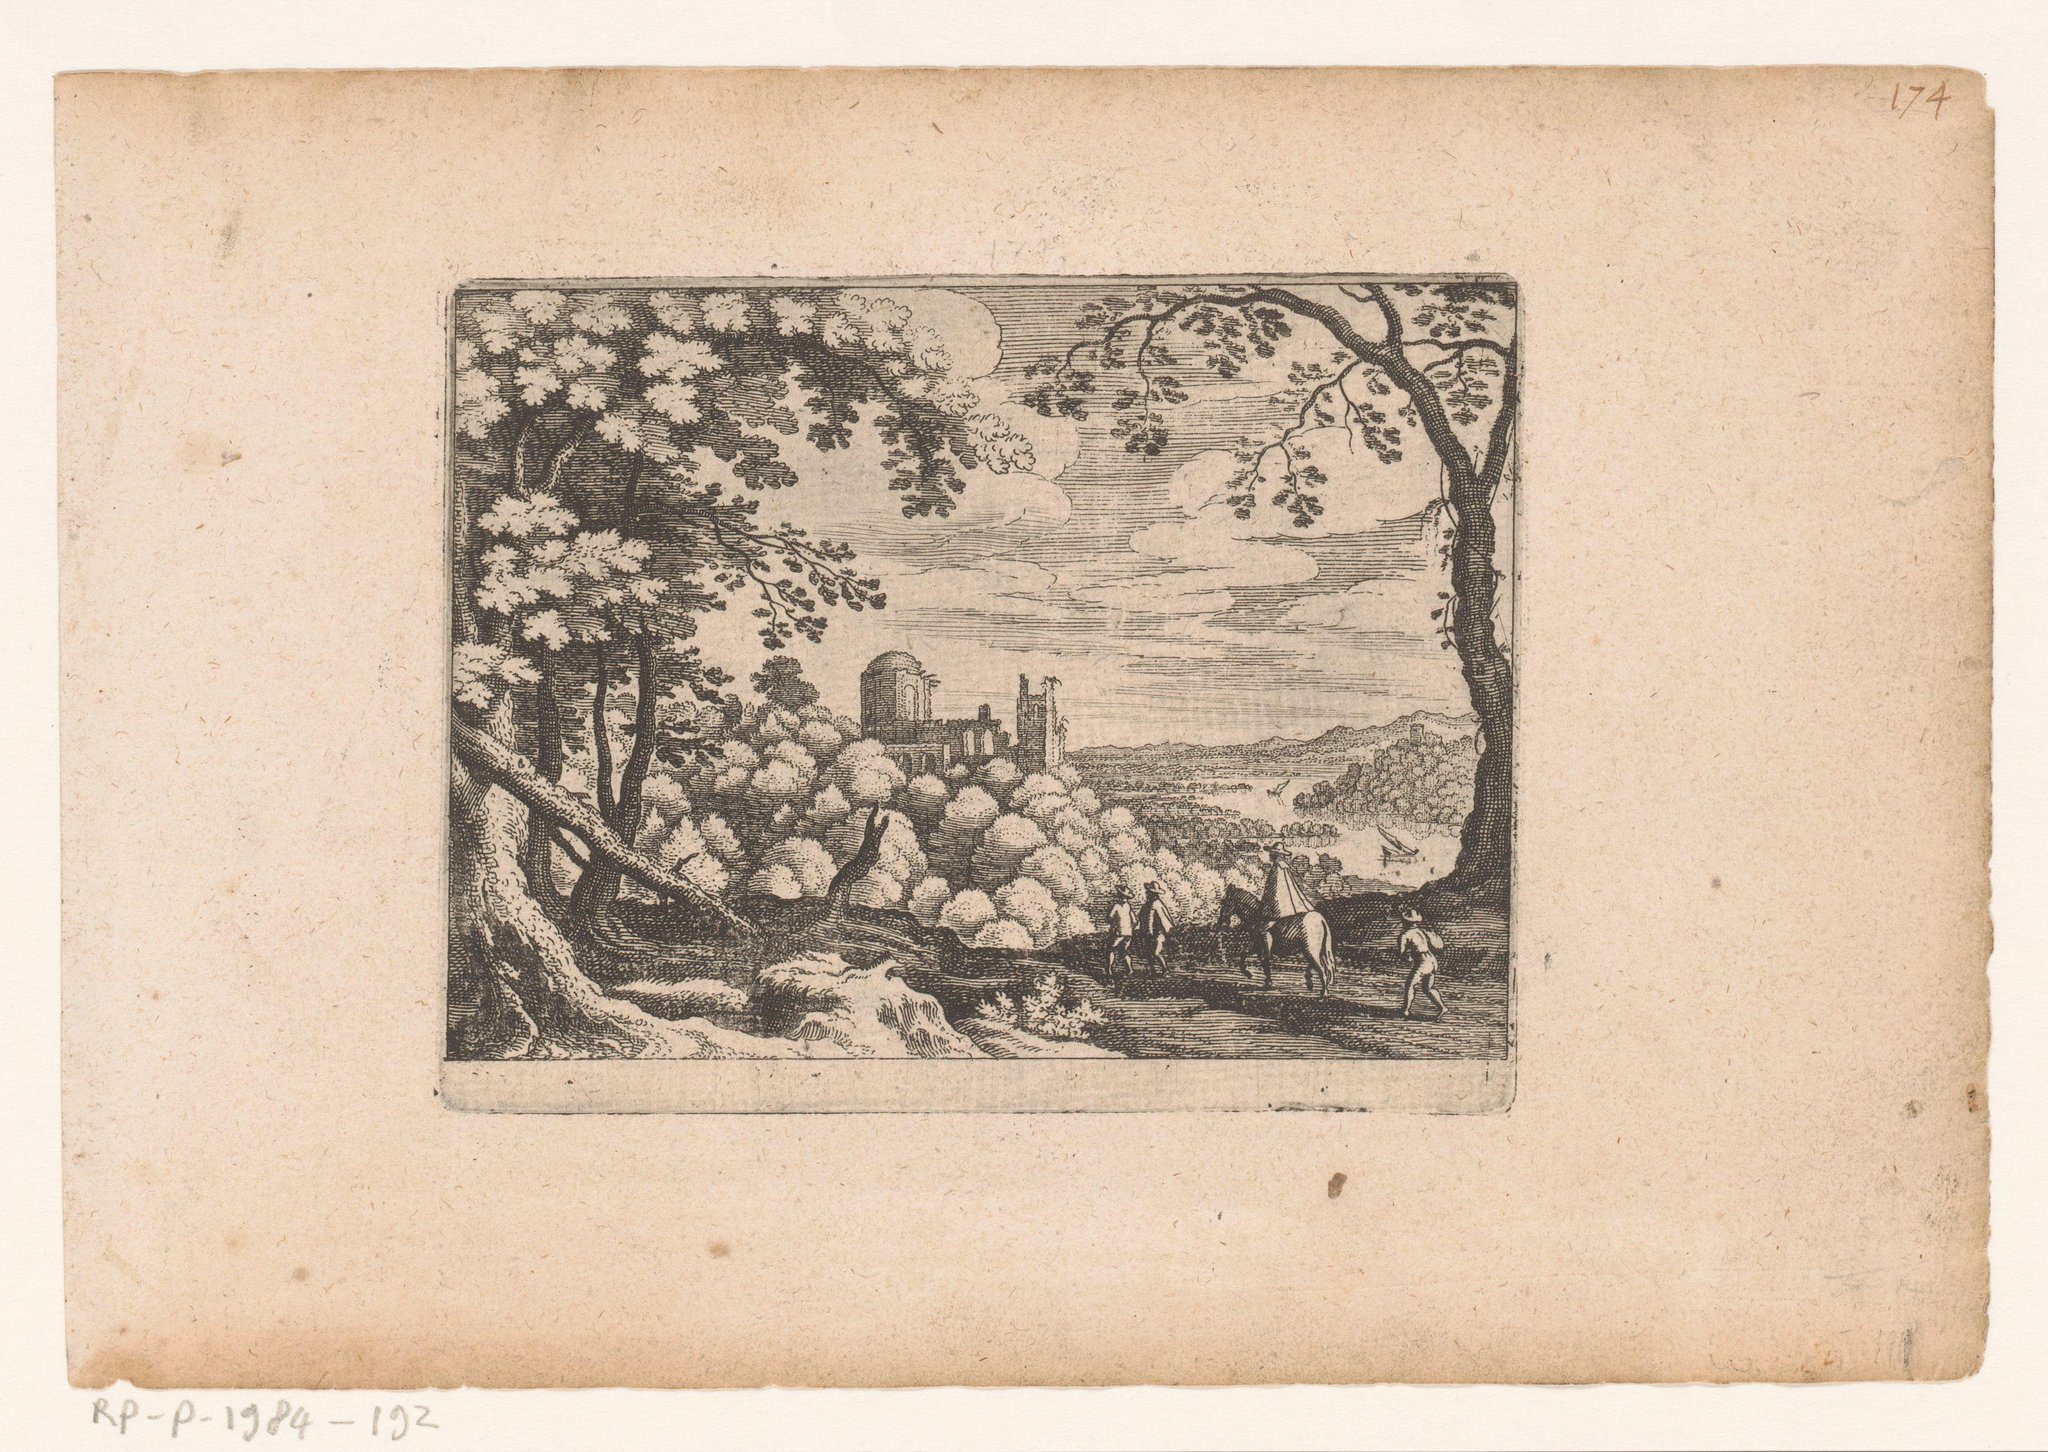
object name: print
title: Landschap met ruïne aan een rivier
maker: matthäus merian (i)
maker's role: print maker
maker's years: 1593-1650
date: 1622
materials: paper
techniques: etching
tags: forest, wood - hh - ideal landscapes, river (+ landscape with figures, staffage), landscape with ruins - ii - ideal landscapes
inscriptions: collector's mark: Lugt 2228